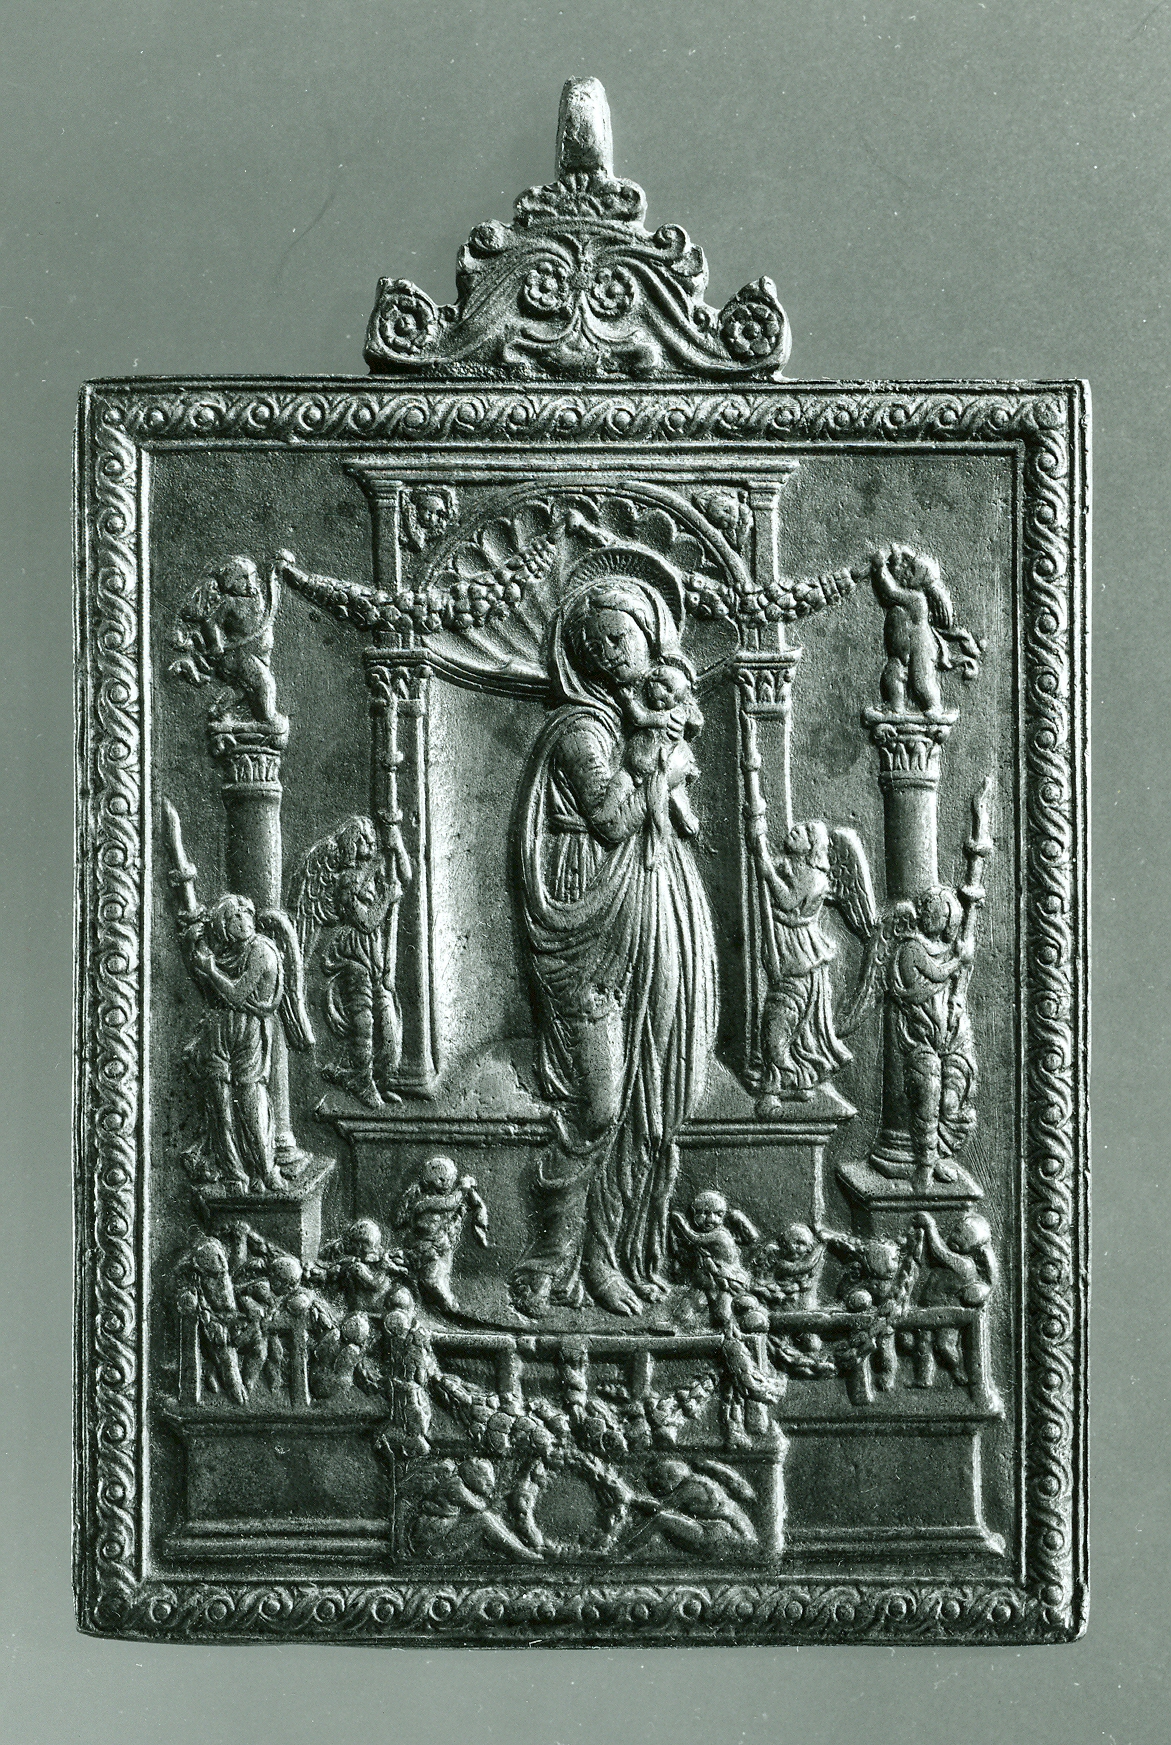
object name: plaquette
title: Pax with the Virgin and Child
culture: italian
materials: copper alloy, patina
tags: madonna and child